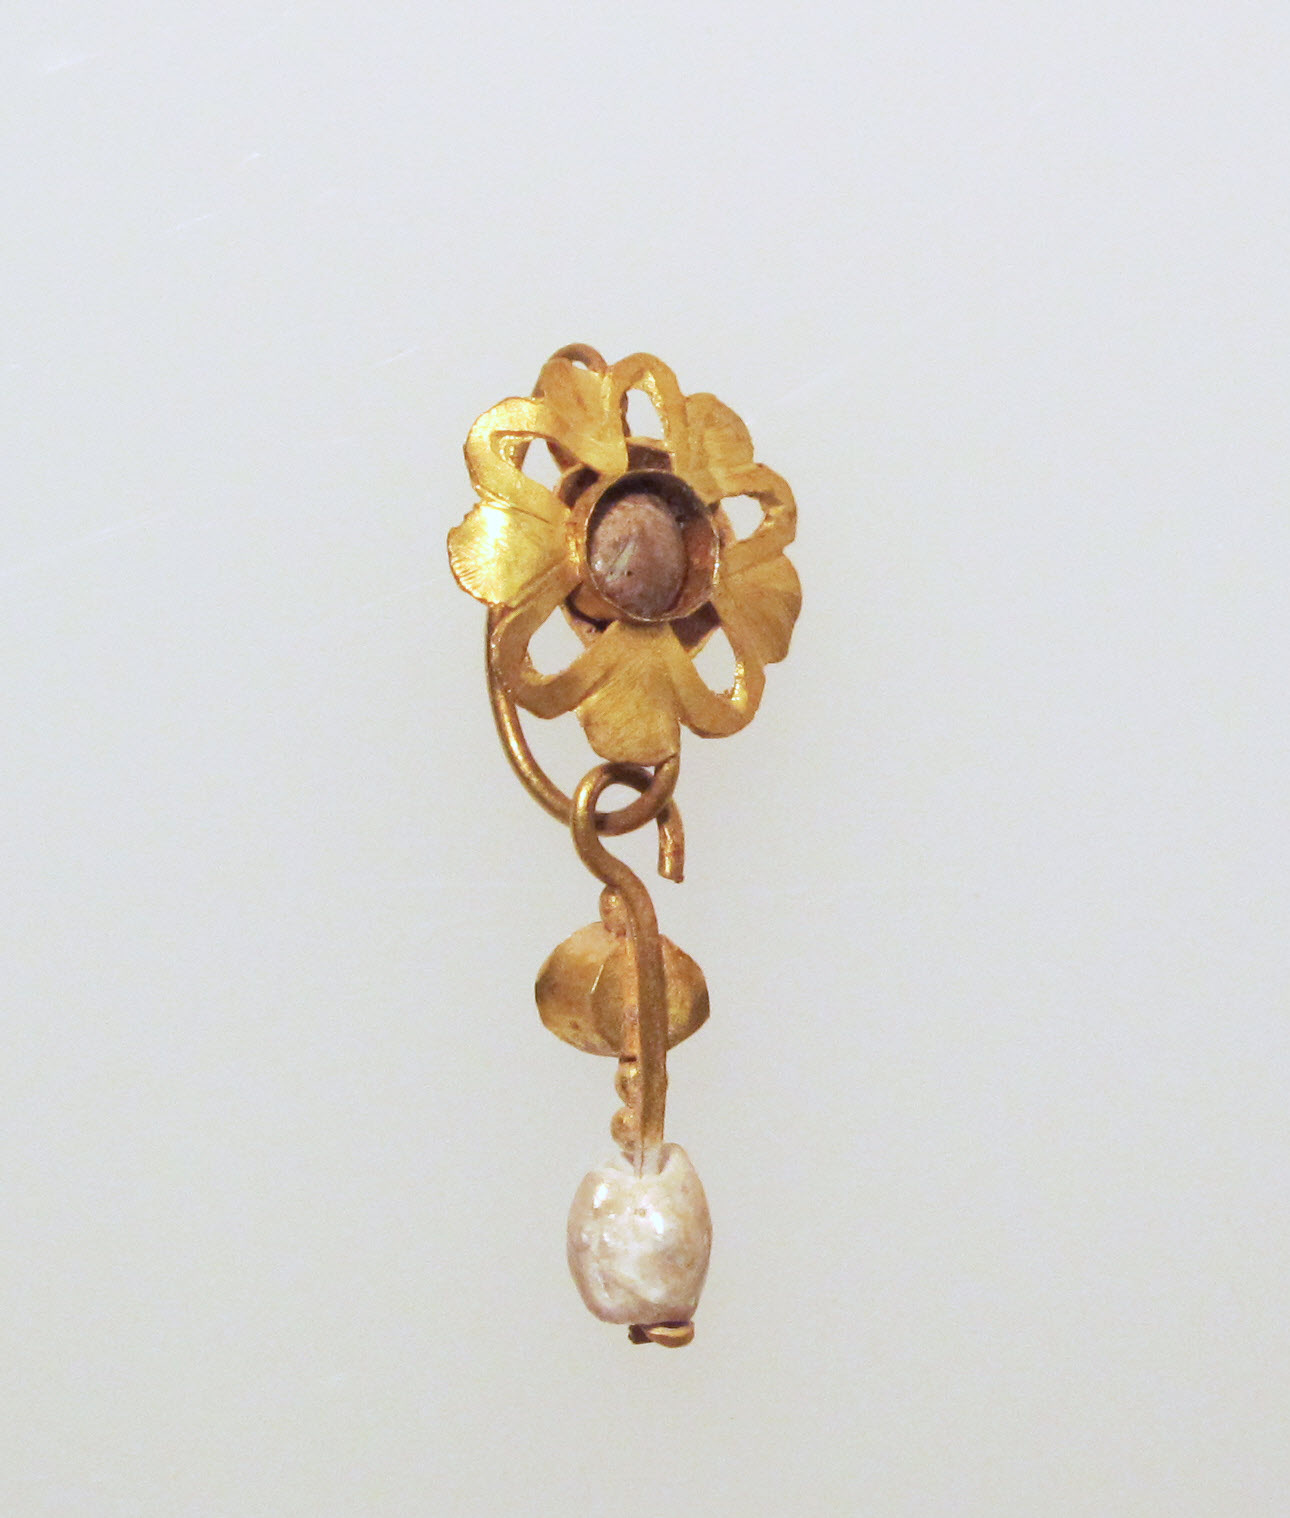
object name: earring with pendant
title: Earring with pendant and beryl and pearl settings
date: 7000 BCE-330 CE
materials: gold, pearl